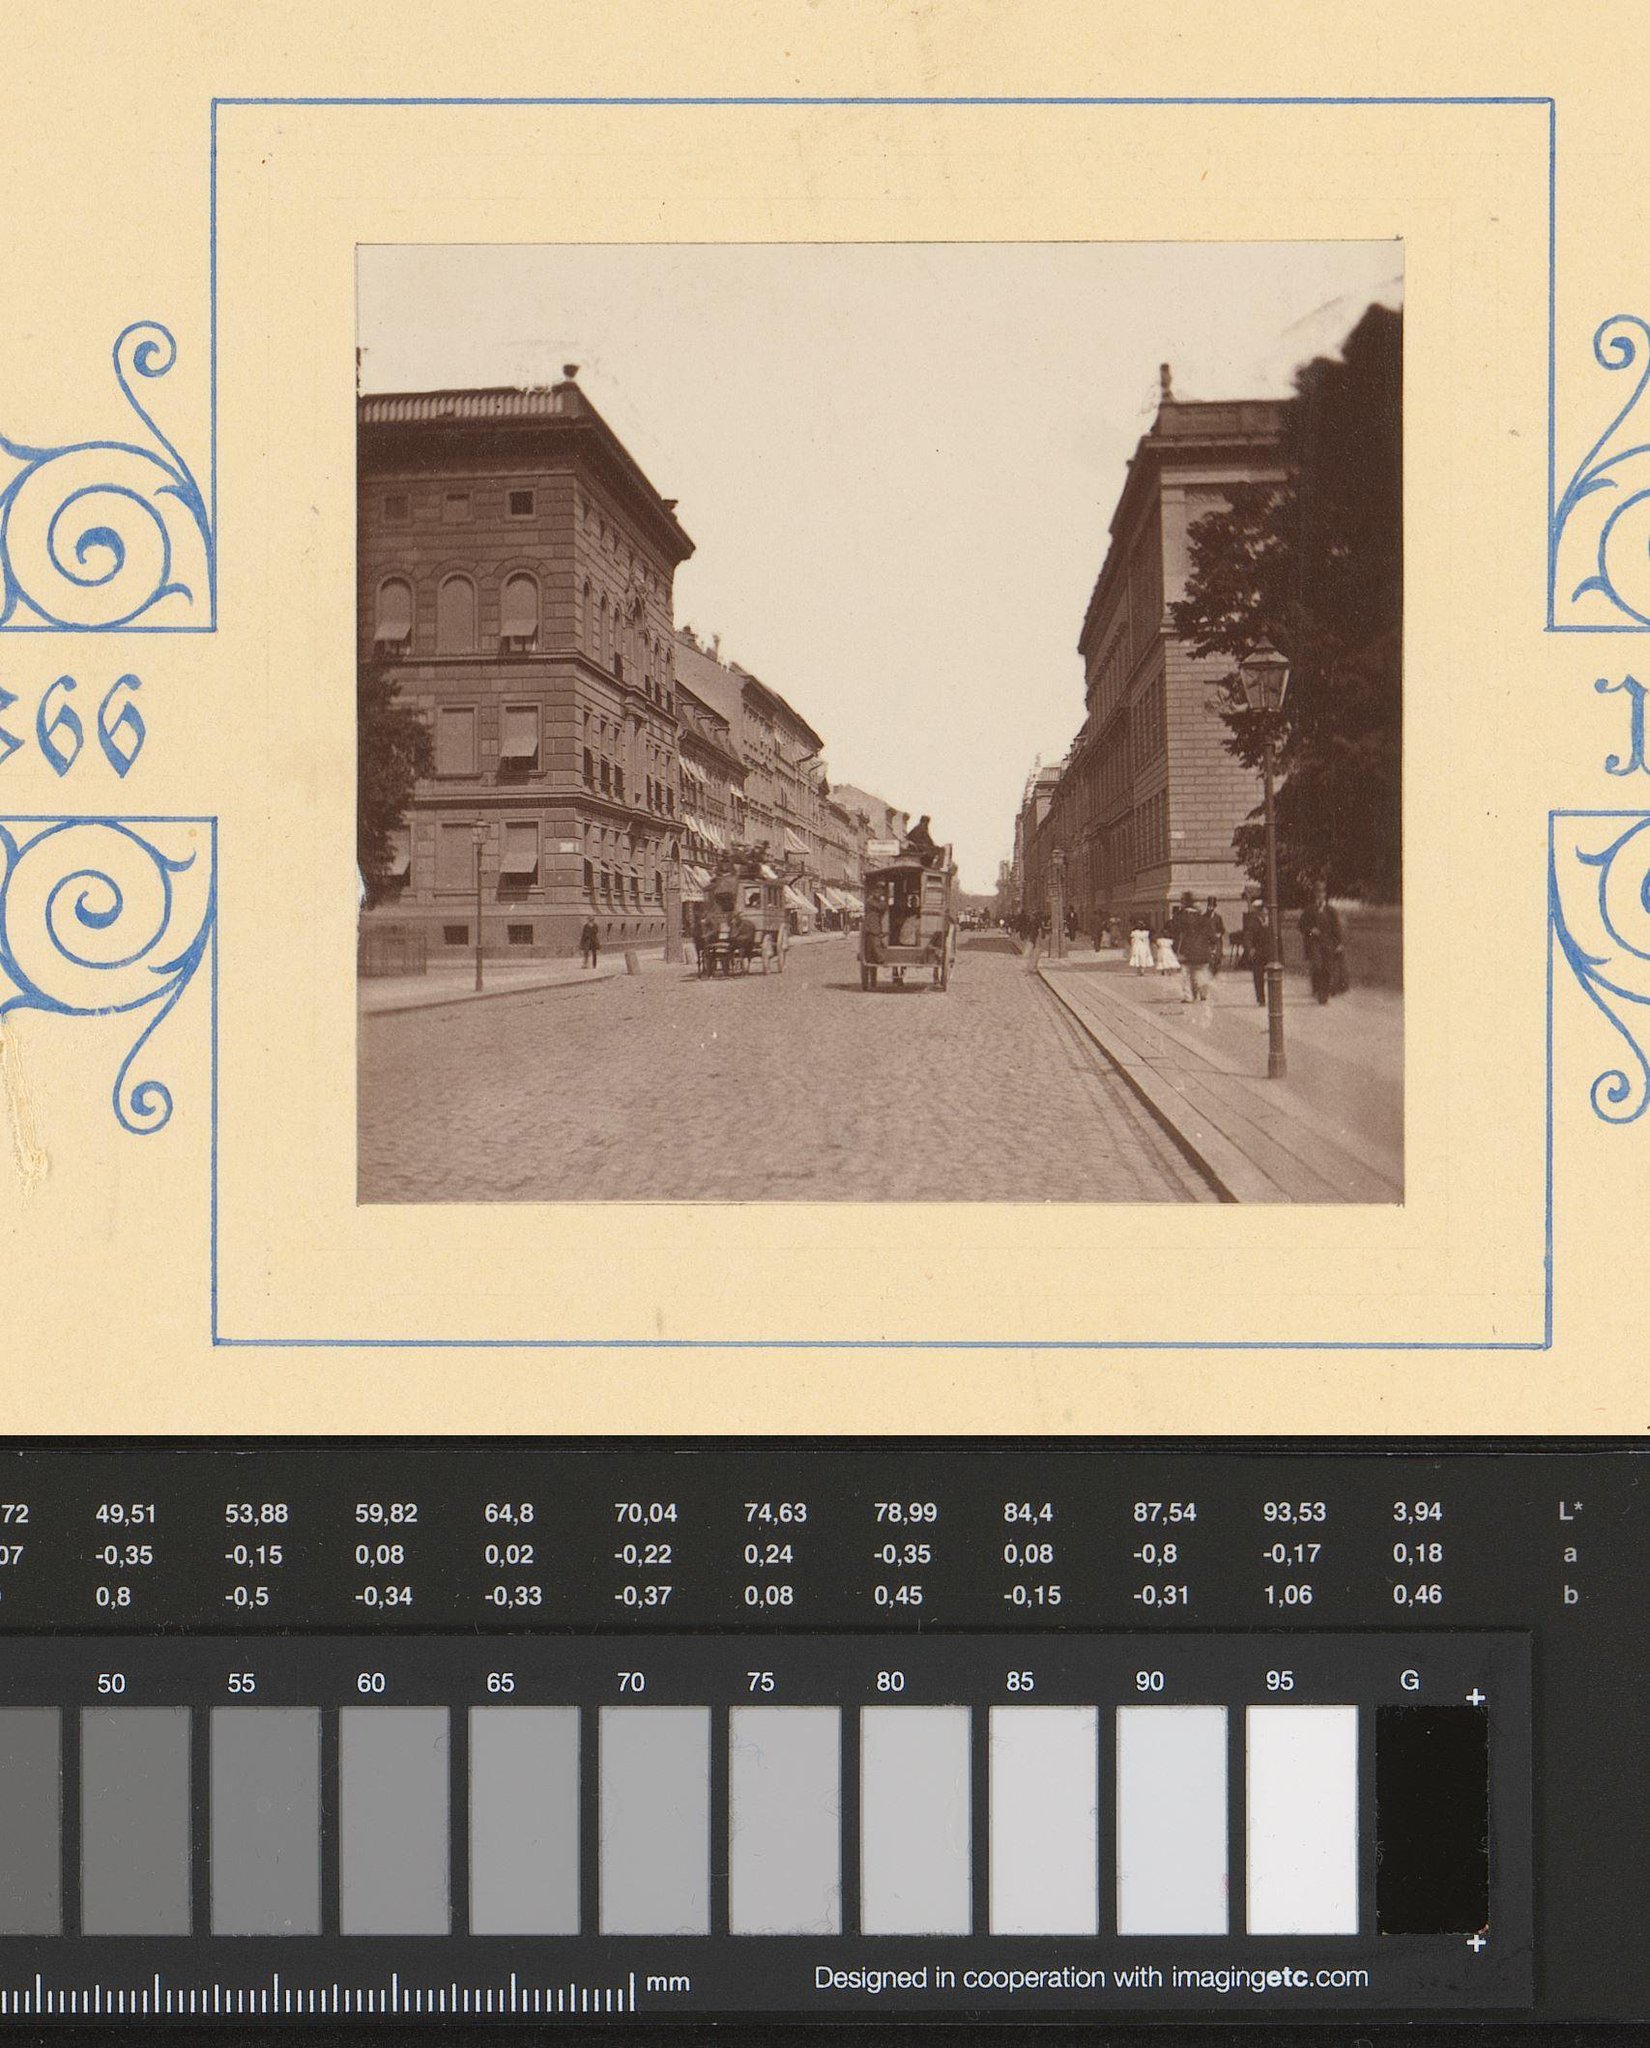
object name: photograph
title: Straatgezicht in Berlijn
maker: Anonymous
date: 1873-1875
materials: paper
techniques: albumen print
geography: berlin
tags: diligence, omnibus, horse-tram, street, berlin